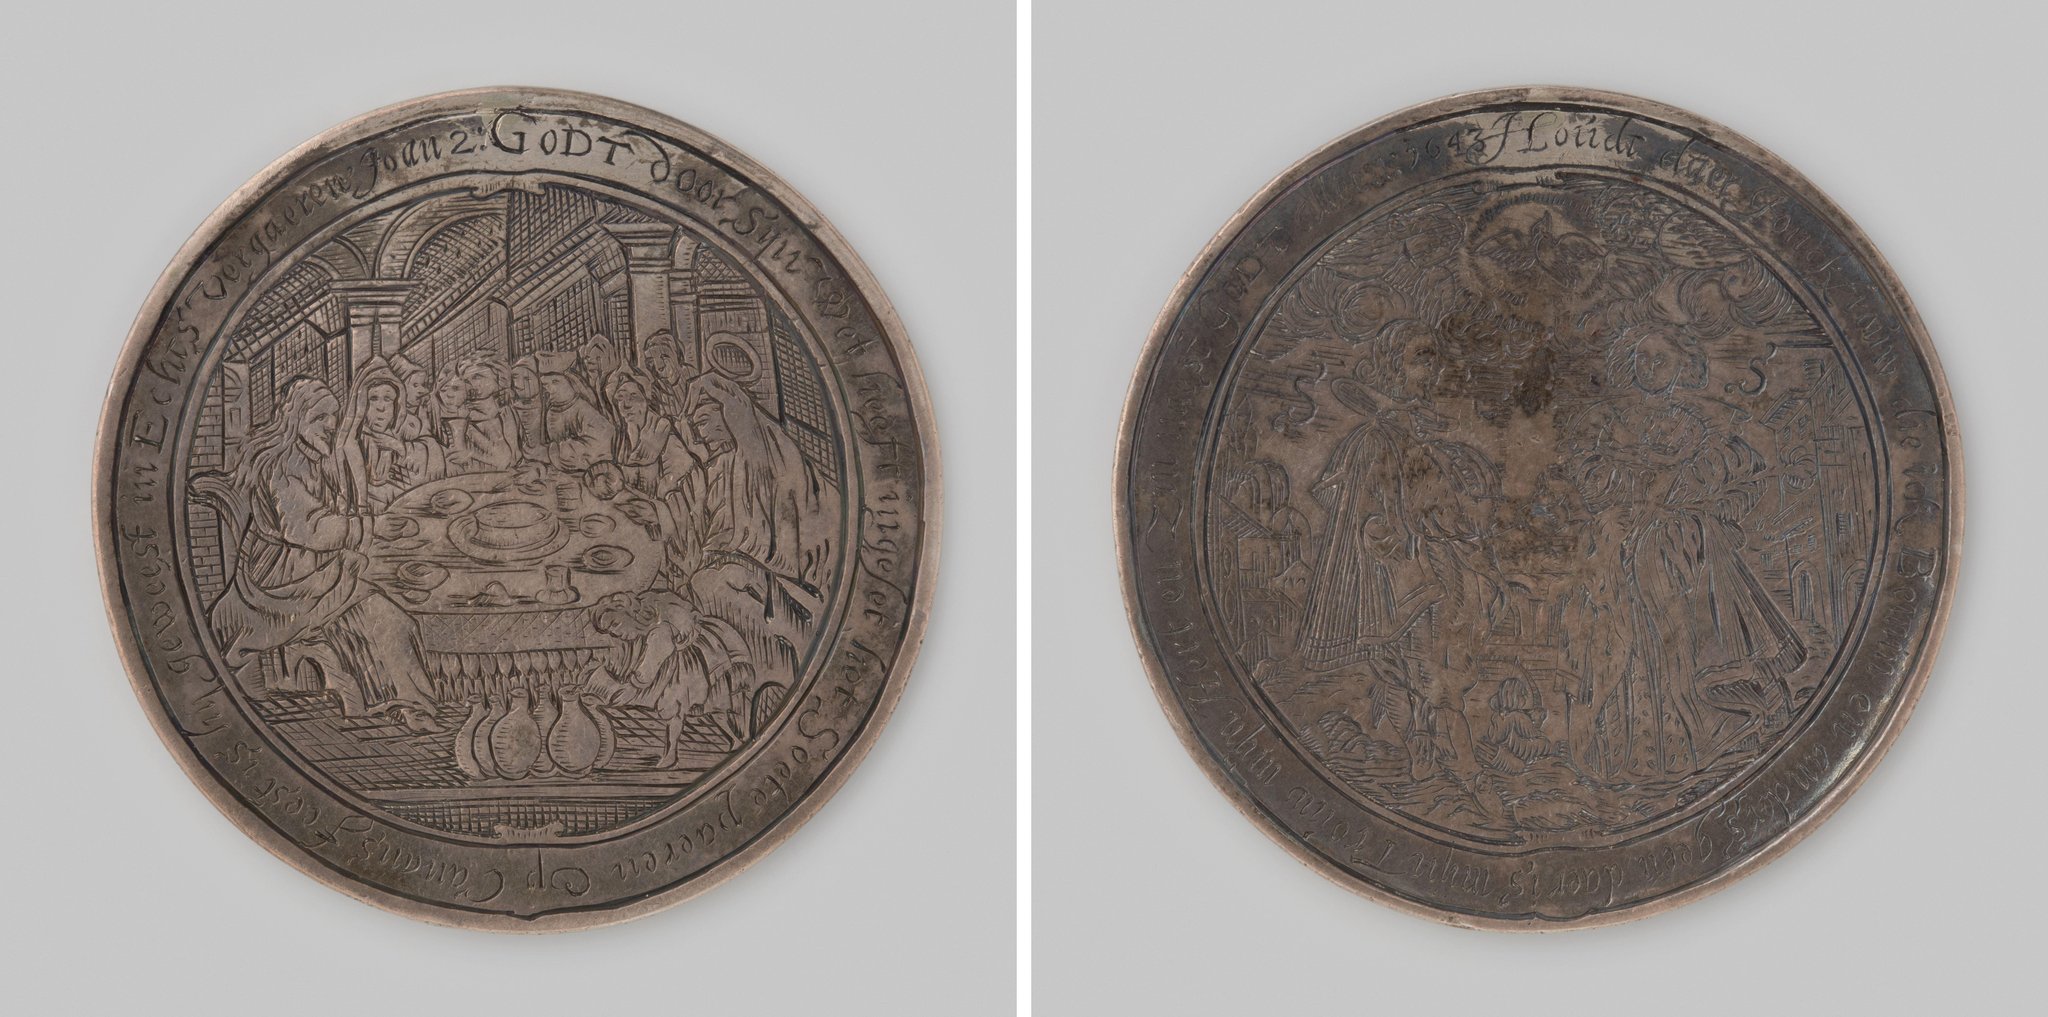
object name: history medal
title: Anonieme gegraveerde huwelijkspenning 1643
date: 1643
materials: silver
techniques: engraving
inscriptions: circumscription: ‘GODT door sijn wet heeft ingeset het Soete paeren Op Cacans feest is hij geweest in Echts Vergaeren' Joan 2:’, circumscription: ‘Houdt daer Jonckfrouw die ick Bemin en anders geen daer is mijn Trouw mijn Hert en Zin naest GODT alleen: 1643’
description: Gegraveerde zilveren penning, op de voorzijde de maaltijd op de bruiloft te Cana, met omschrift, op de keerzijde een rijkgekleed echtpaar waarvan de man een brandend hart aan de vrouw geeft, met bovenaan engelen en de Heilige Geest, onderaan Cupido en op de achtergrond een stad, in het veld S - S, met omschrift.